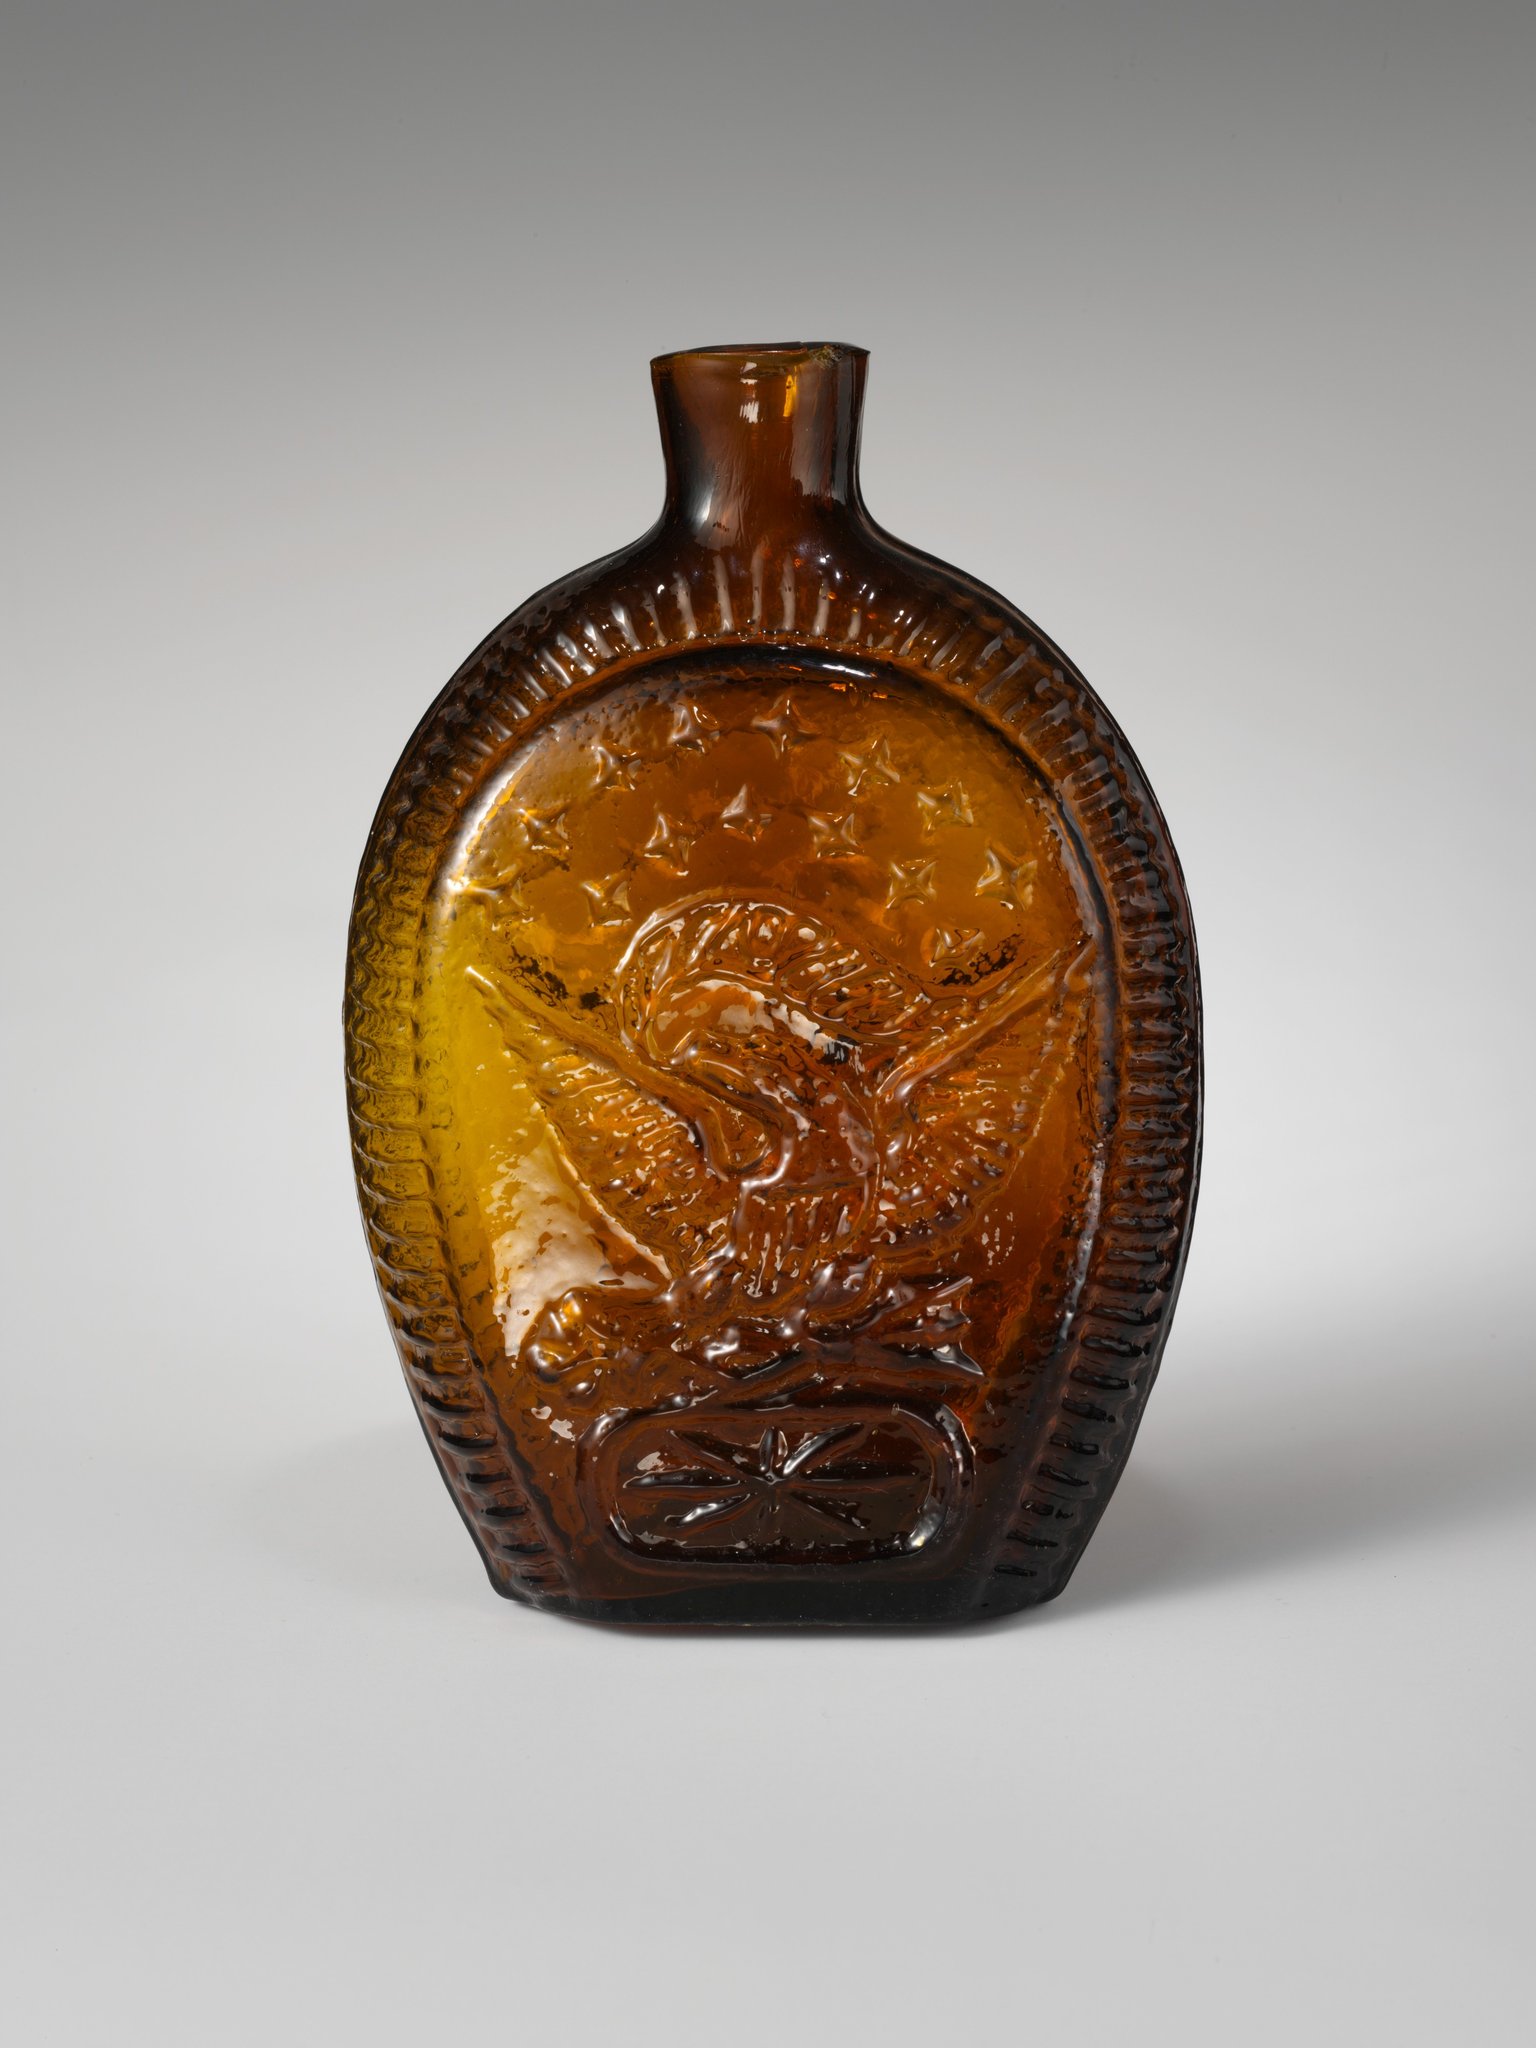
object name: flask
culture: american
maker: kentucky glass works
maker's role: maker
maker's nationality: american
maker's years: 1850-1855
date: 1825-1860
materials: amber, glass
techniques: glassblowing, molding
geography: united states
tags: eagles